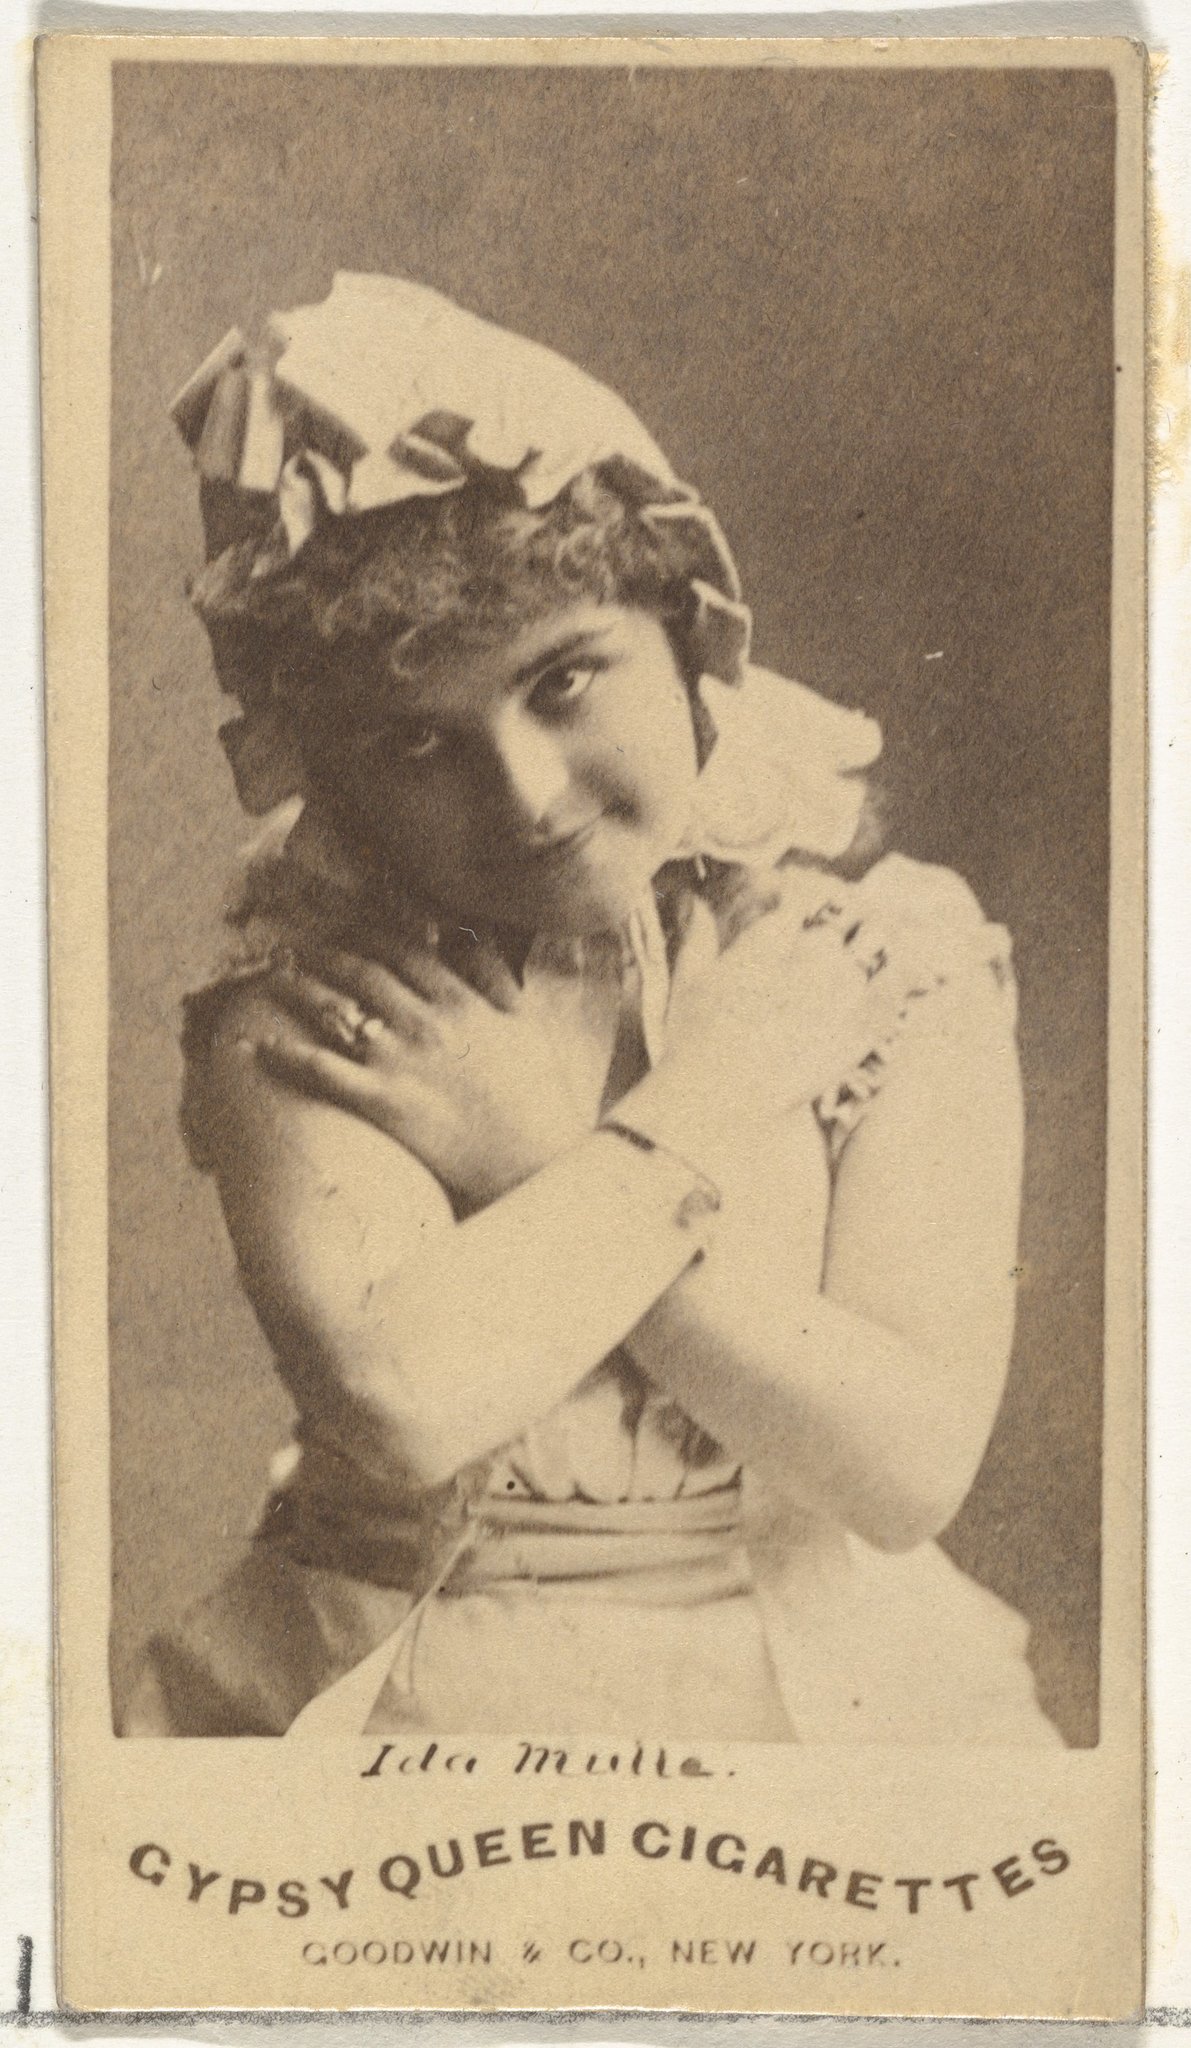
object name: photograph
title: Ida Mulle, from the Actors and Actresses series (N171) for Gypsy Queen Cigarettes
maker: goodwin & company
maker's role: publisher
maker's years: 1850-1950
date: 1886-1890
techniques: albumen silver print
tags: portraits,women,actresses